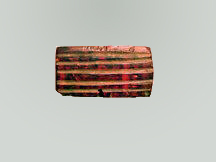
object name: fibula, fragment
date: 7000 BCE-330 CE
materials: amber